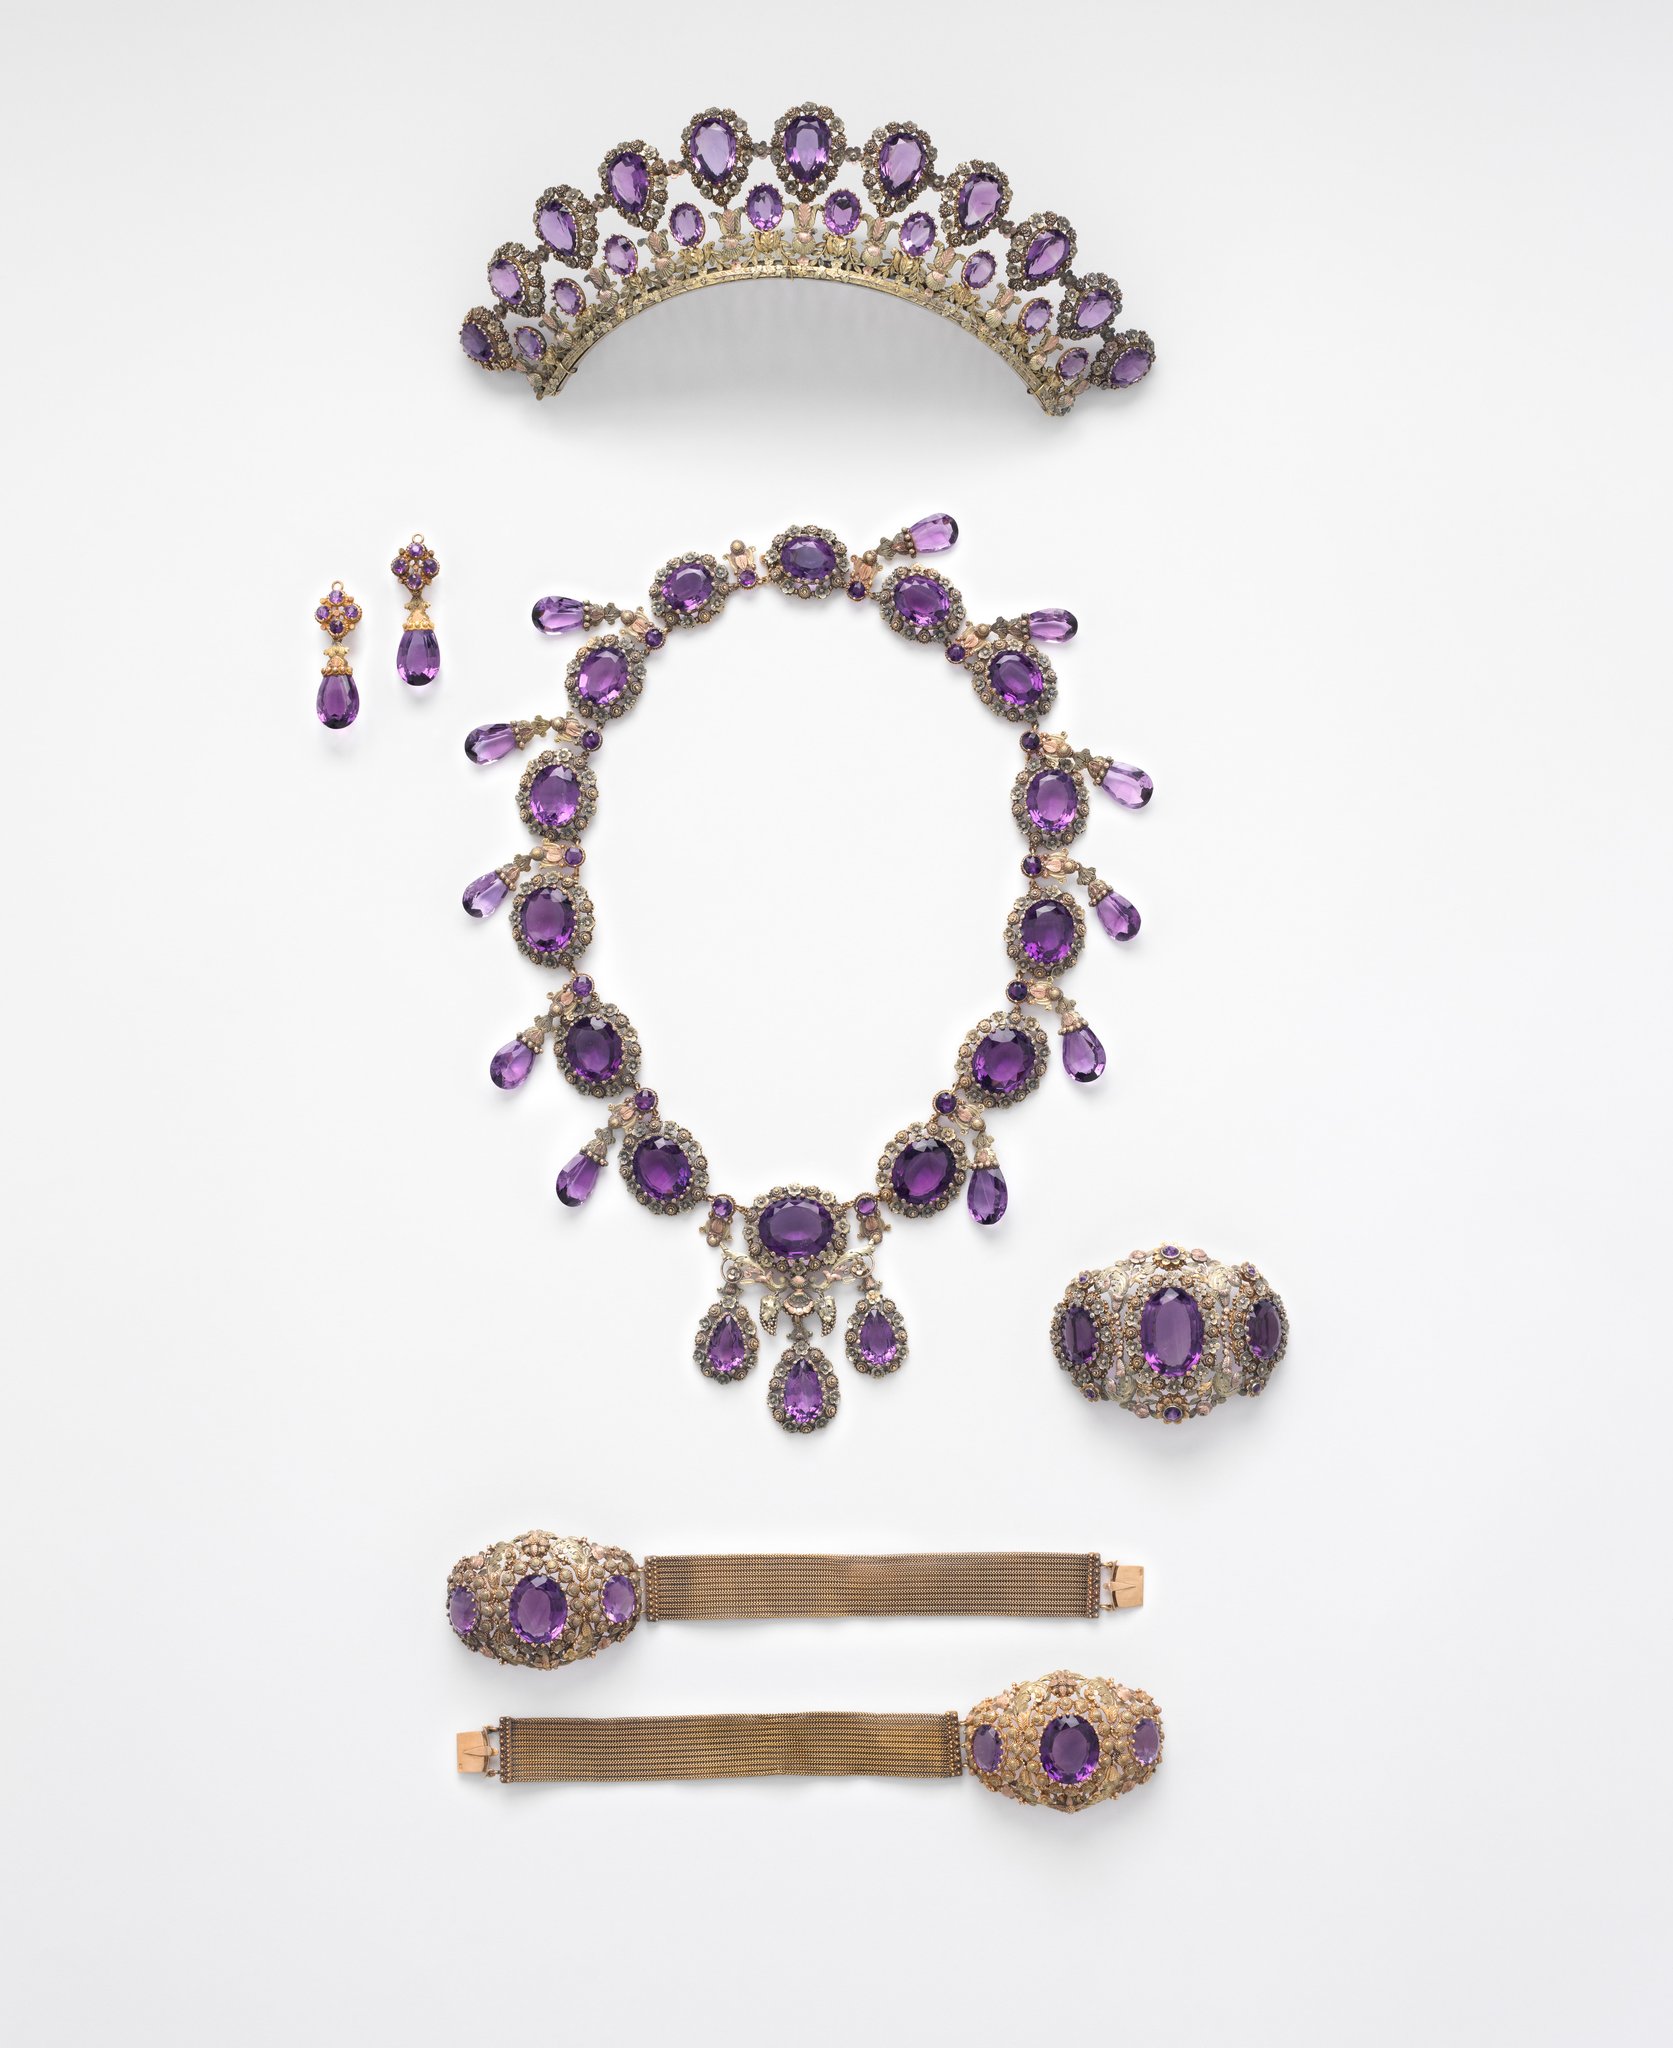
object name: bracelet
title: Bracelet (part of a set)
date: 1830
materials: amethyst, gold